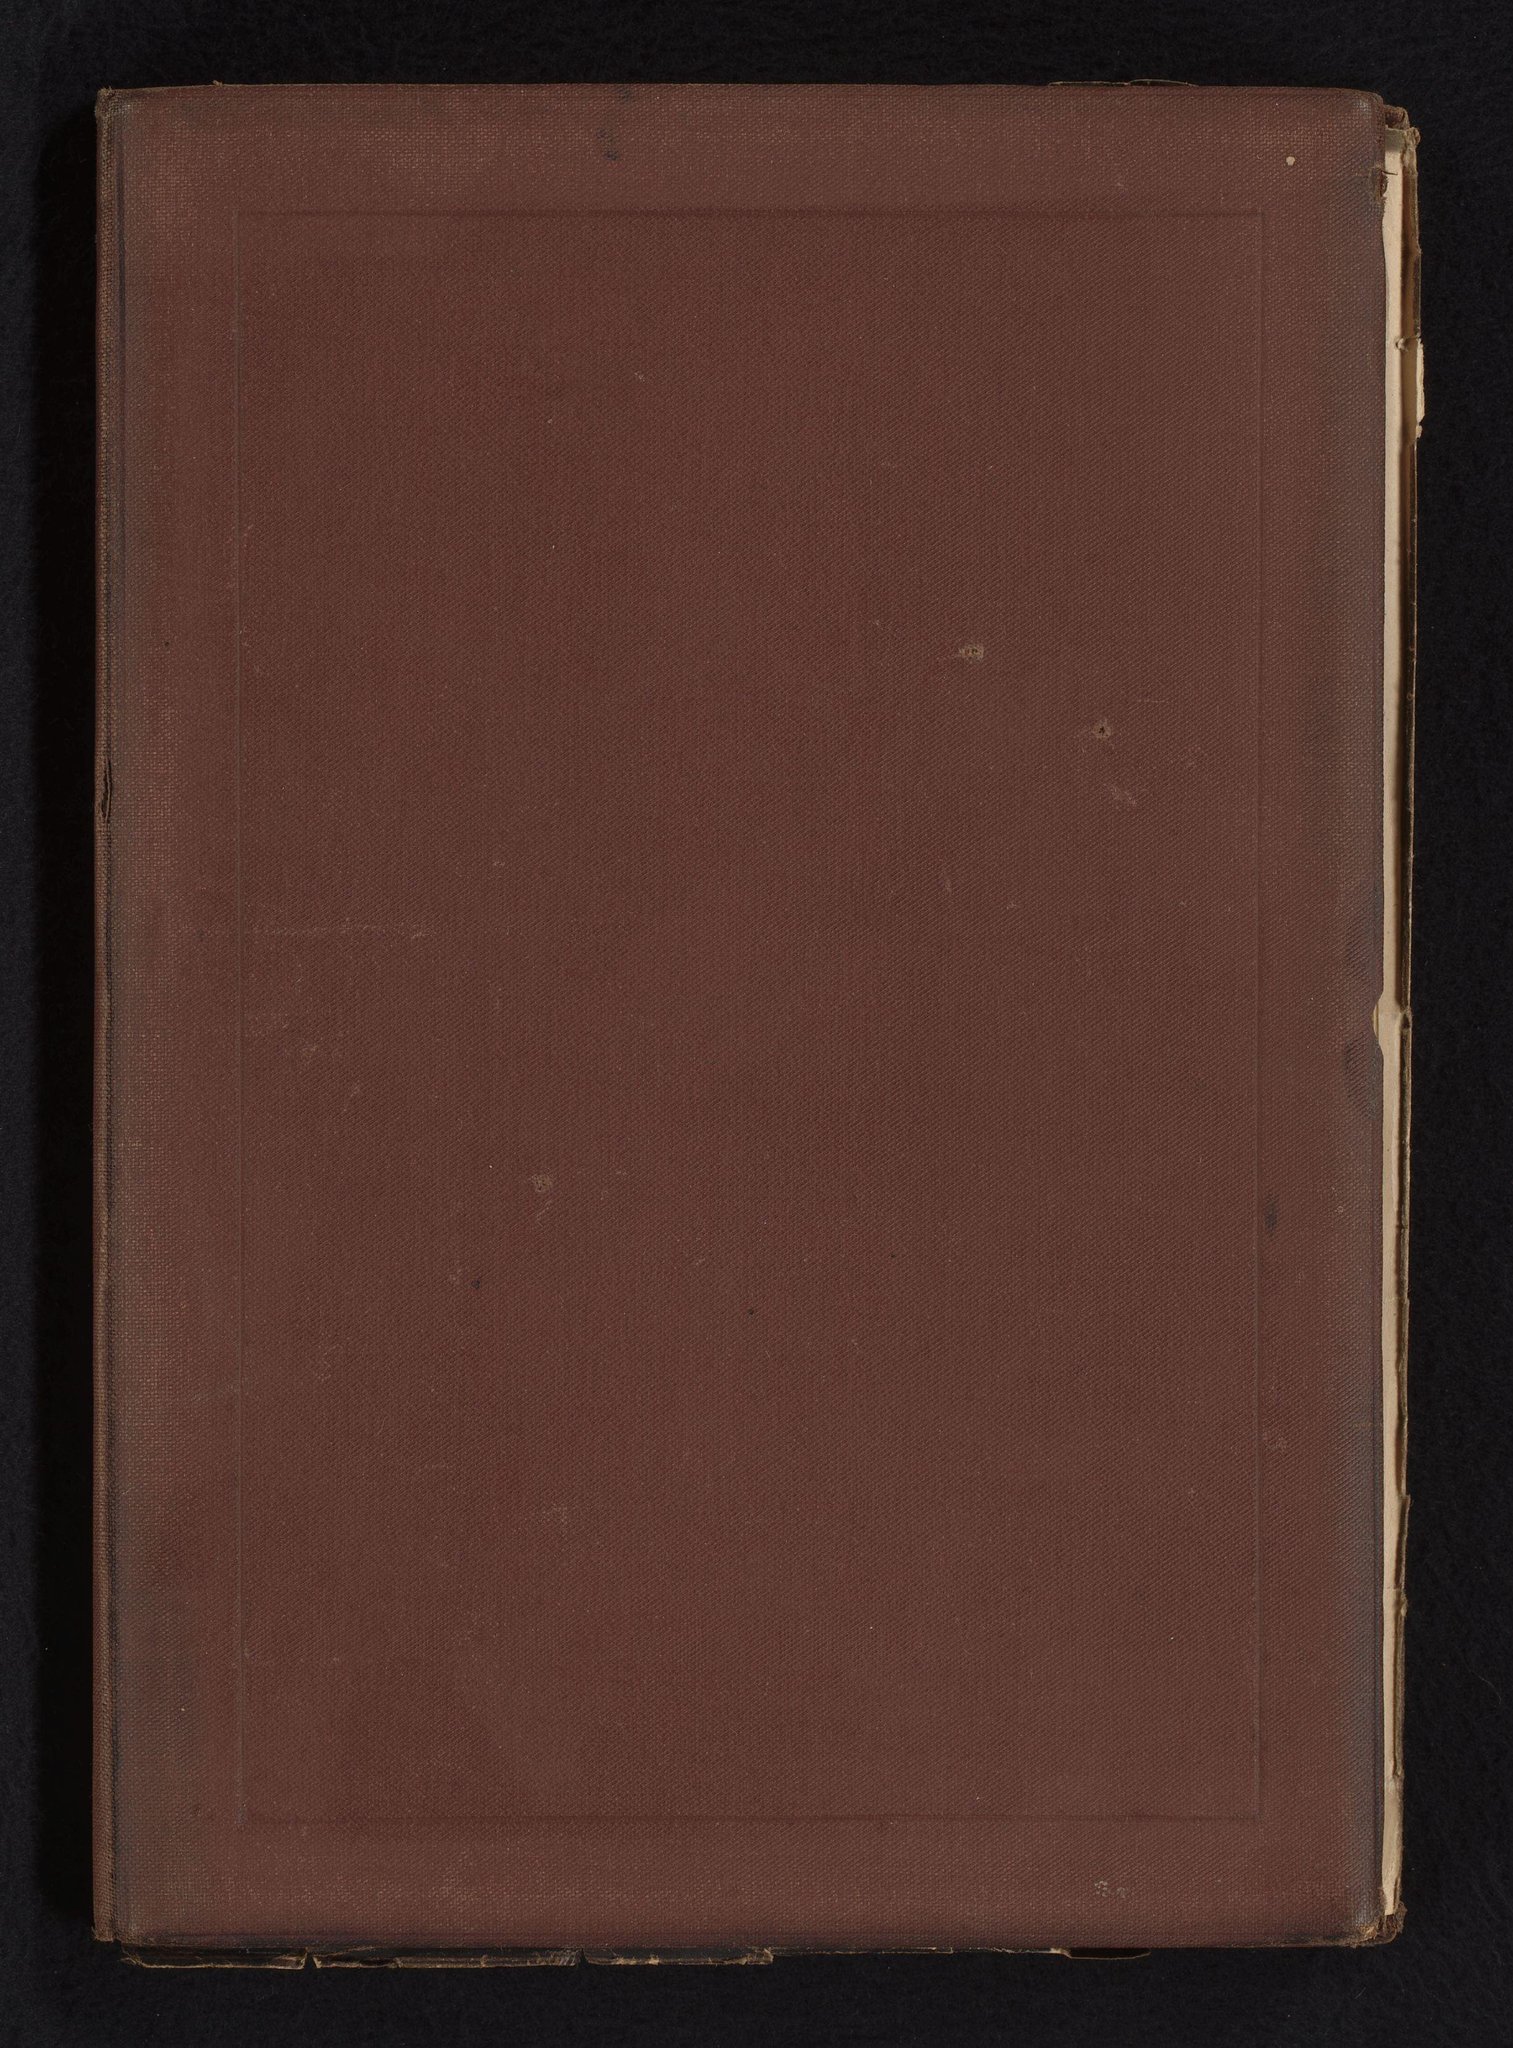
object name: photograph album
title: Nederlands poëziealbum met vijf portretten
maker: Anonymous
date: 1880-1910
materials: cardboard, linen, paper, photographic support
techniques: albumen print, drawing, hand coloring, rotogravure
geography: netherlands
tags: adolescent, young woman, maiden, historical persons - bb - woman, road, path, portrait of actor, actress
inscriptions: collector's mark: ‘DIENST/ VERSPREIDE/ RIJKSKOLLEKTIES/ (...) A 843’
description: Poëziealbum met in totaal vier foto's en een fotomechanische afdruk. Het album bevat een foto van een bospad, drie miniatuurportretten van jonge vrouwen op postzegelformaat en een portret van actrice Annie van Ees tijdens een scène van een toneelstuk. Alle afbeeldingen zijn gemaakt door een anonieme fotograaf of vervaardiger. Verder bevat het album vele handgeschreven gedichten en (deels gekleurde) tekeningen.